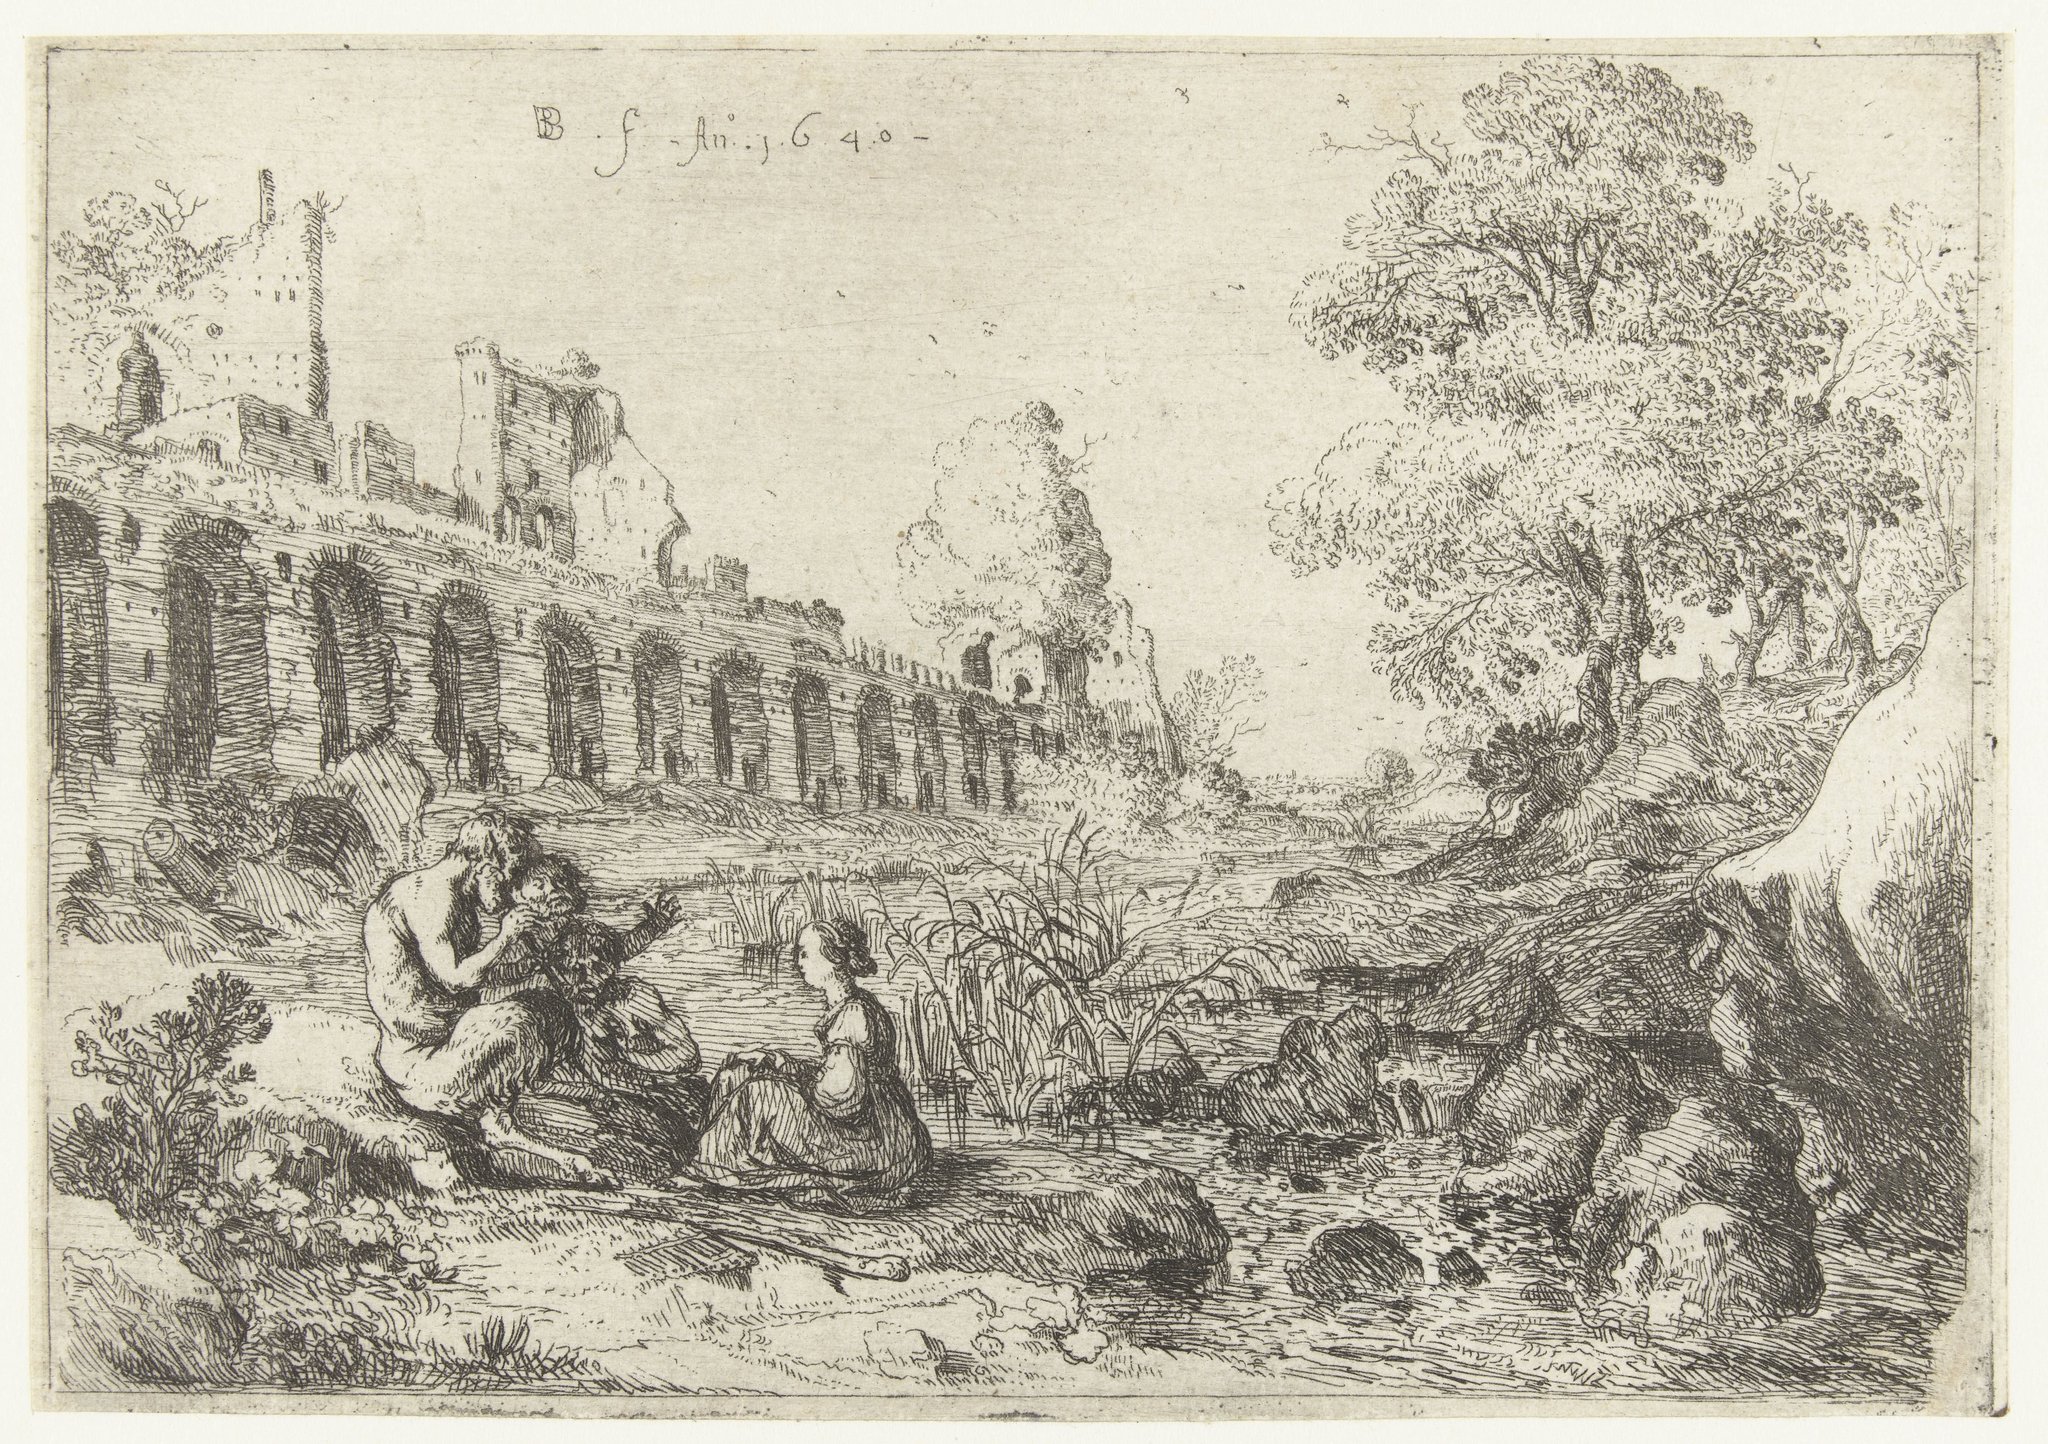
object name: print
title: Nimf Corsica en de satyrs zittend in een landschap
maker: bartholomeus breenbergh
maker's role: draughtsman, print maker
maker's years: 1599-1657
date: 1640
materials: paper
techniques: etching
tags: nymphs (in general); 'ninfe in commune' (ripa)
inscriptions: collector's mark: Lugt 240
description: Nimf Corsica en de satyrs zittend in een landschap. Prent voor uitgave Il Pastor Fido van Guarini.